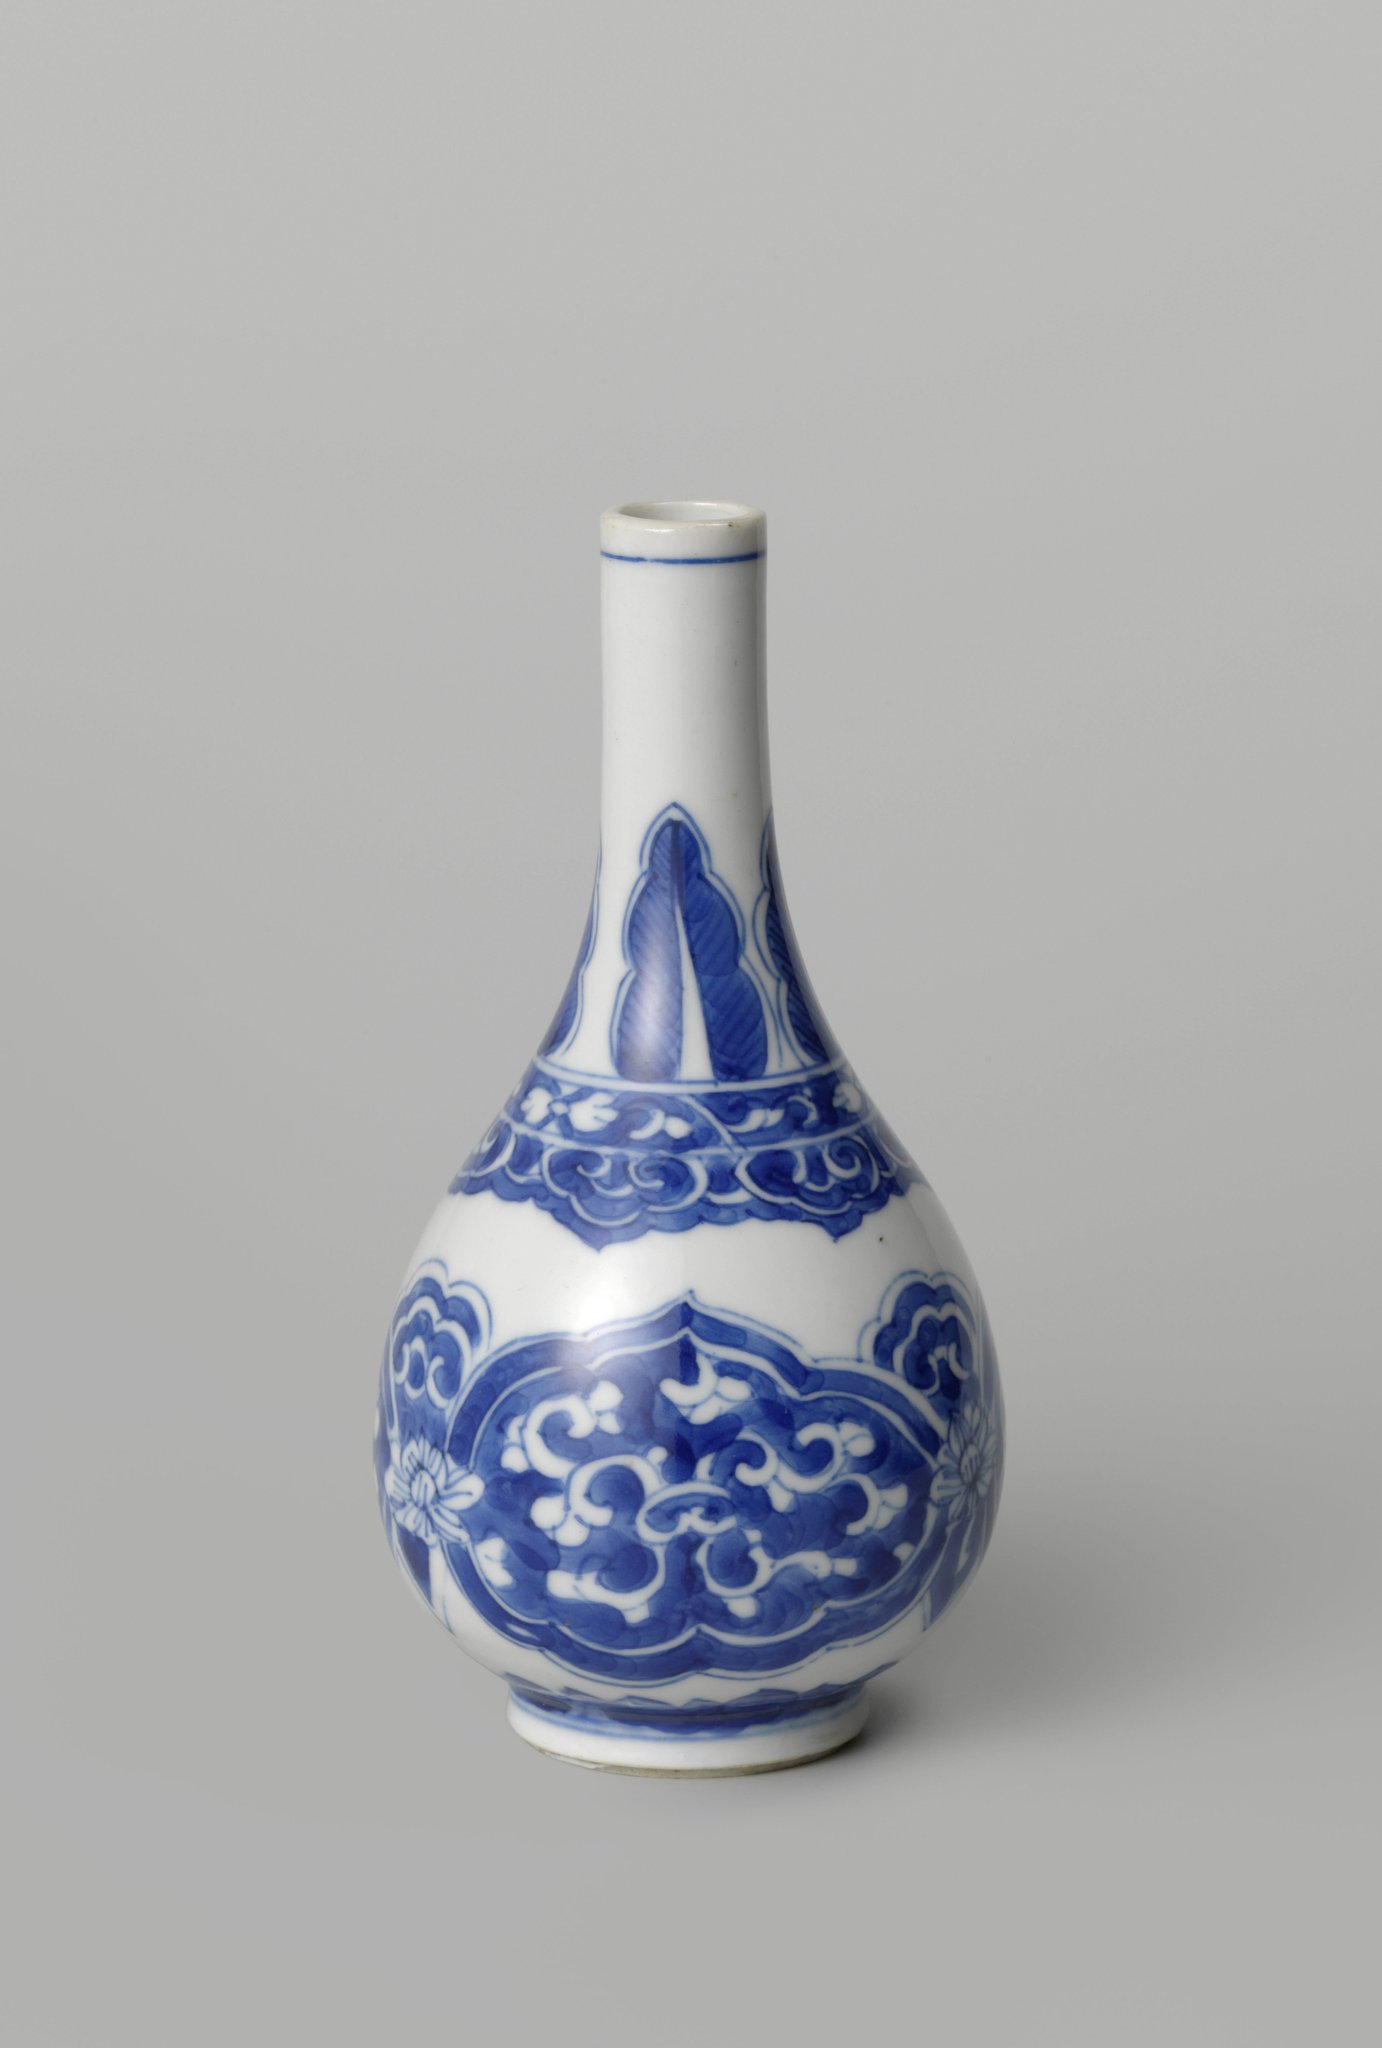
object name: vase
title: Pear-shaped bottle vase with floral scrolls and petals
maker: Anonymous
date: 1680-1720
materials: cobalt, glaze, paint, porcelain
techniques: firing, turning, vitrification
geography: china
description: AK-NM-6733 Twee vazen • Blauw-wit Kangxi-porselein • Lambrequin- of ruyi-ornament • Onderdeel van Royers porseleincollectie • Oorspronkelijk drie exemplaren (Inventaris 1876) Hier is het ruyi-motief nadrukkelijk aanwezig: in de brede band met geschakelde velden op de buik en in de smalle band op de schouder. Het geheel geeft een rustig beeld met een evenwichtige verdeling van het blauw en wit, geheel passend bij de visie van Daniël Marot. Zie ook de toelichting bij AK-NM-6720.